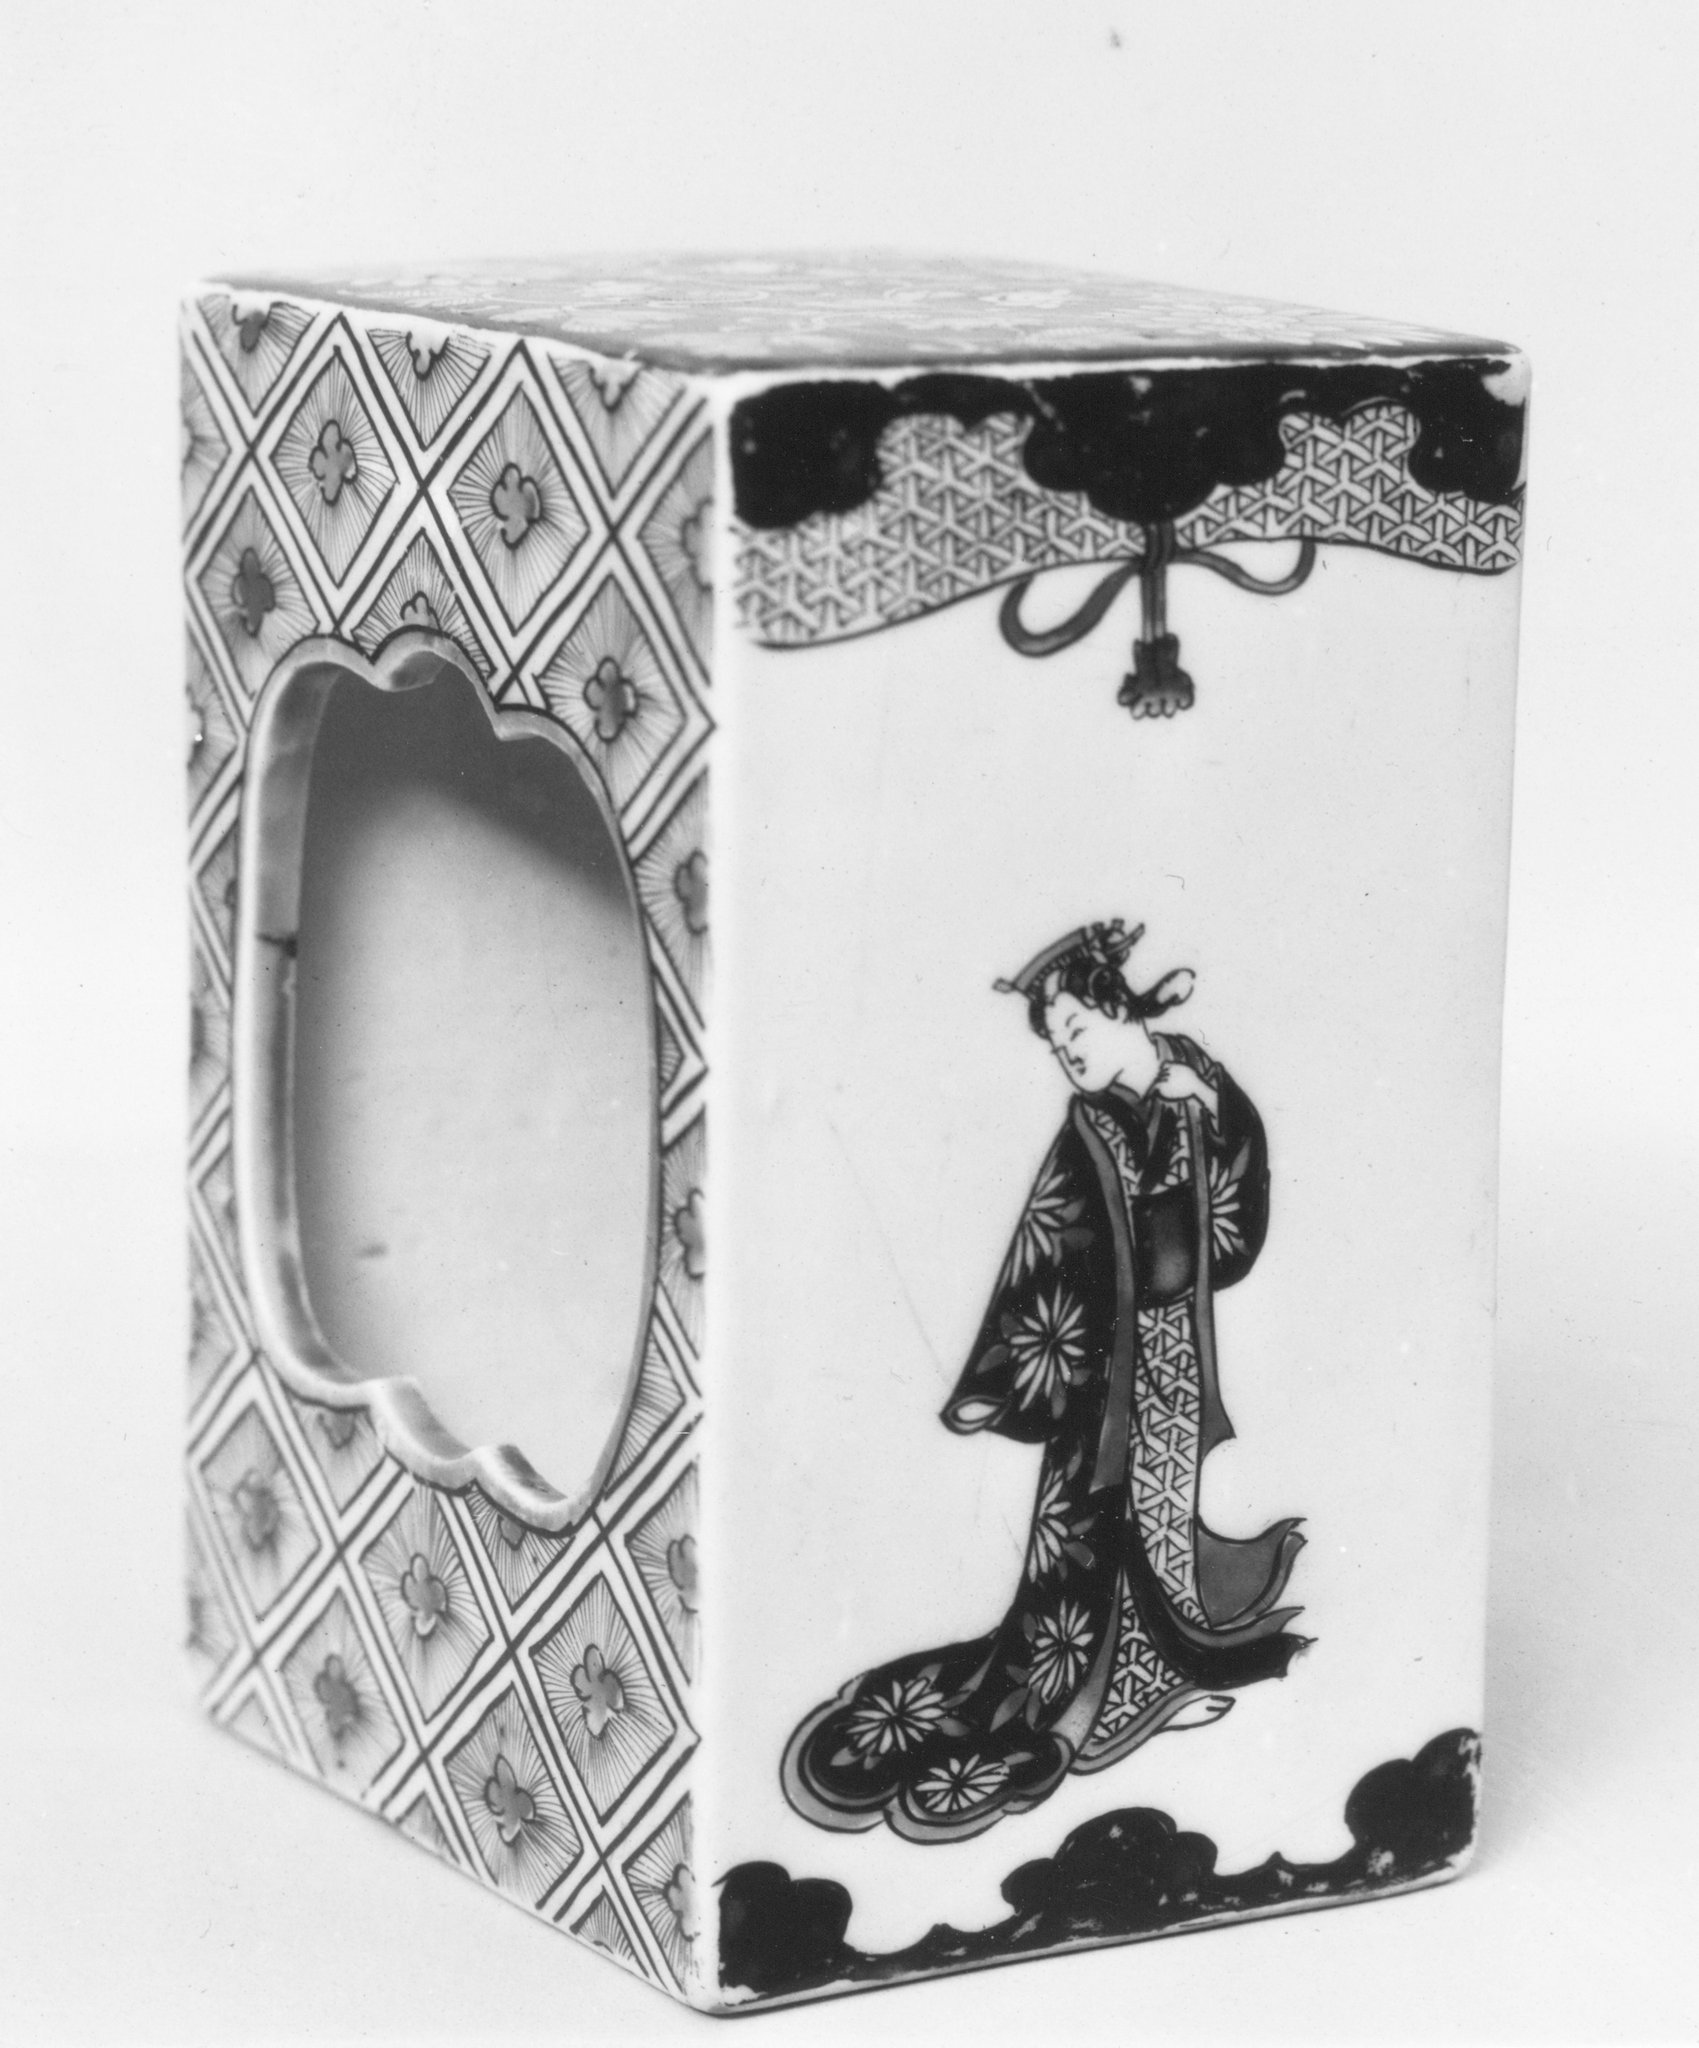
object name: vase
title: Square Lamp (andon) with Design of an Idealized Woman Behind a Curtain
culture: japanese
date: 1760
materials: enamel, porcelain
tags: women